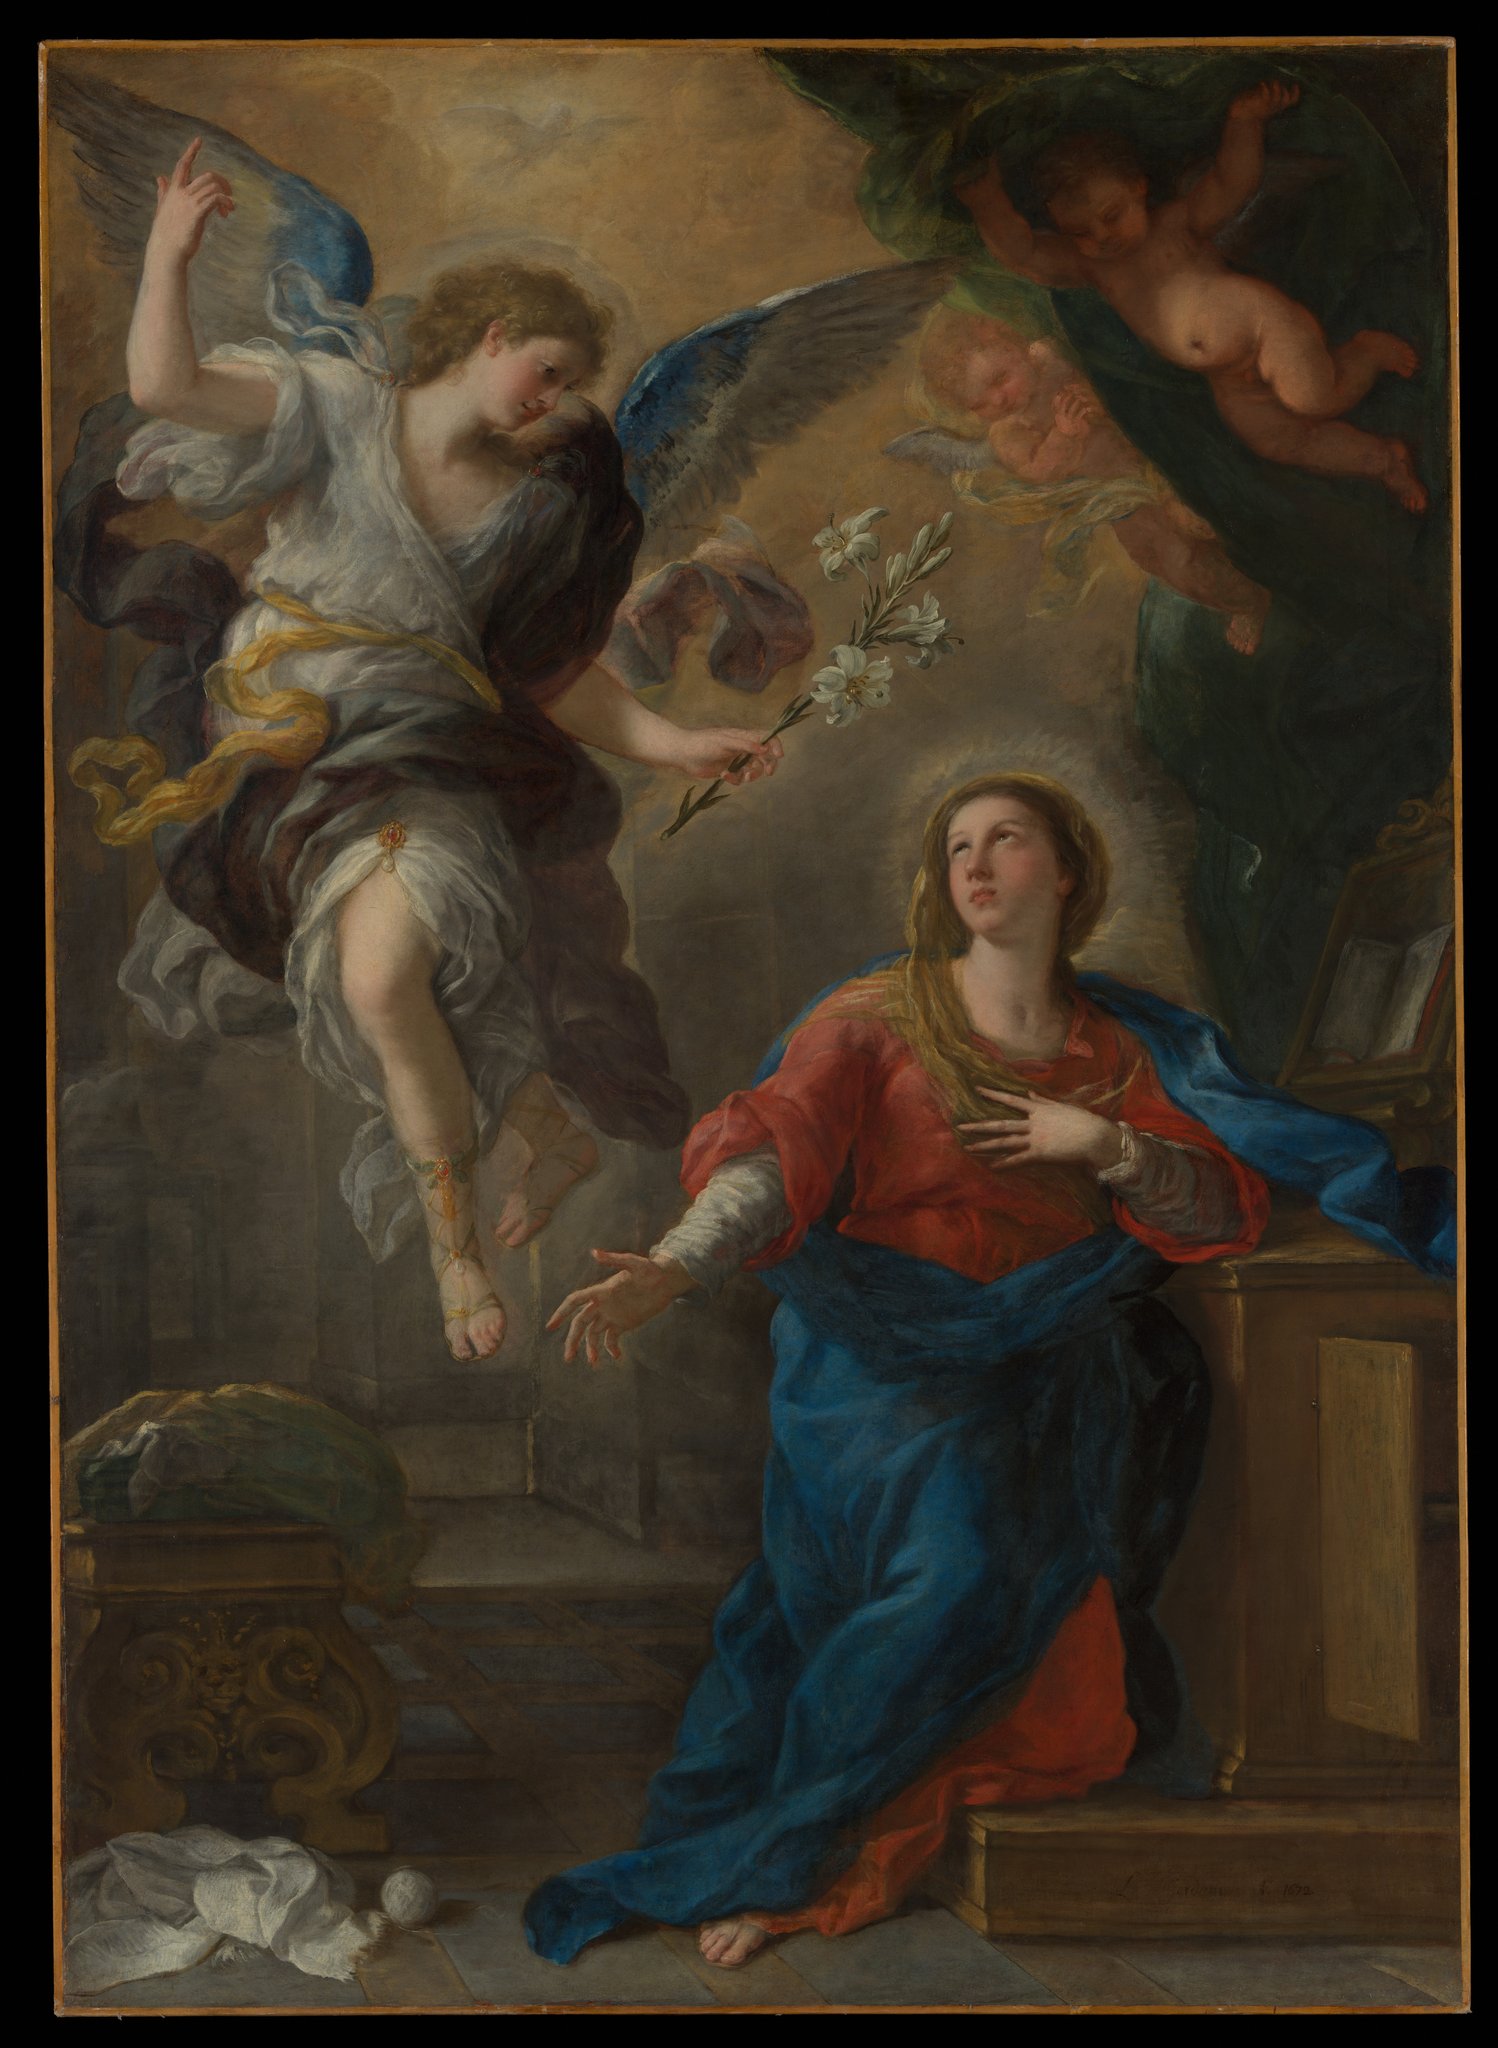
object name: painting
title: The Annunciation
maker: luca giordano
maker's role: artist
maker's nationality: italian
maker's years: 1634-1705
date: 1672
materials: canvas, oil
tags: lilies,angels,virgin mary,archangel gabriel,annunciation